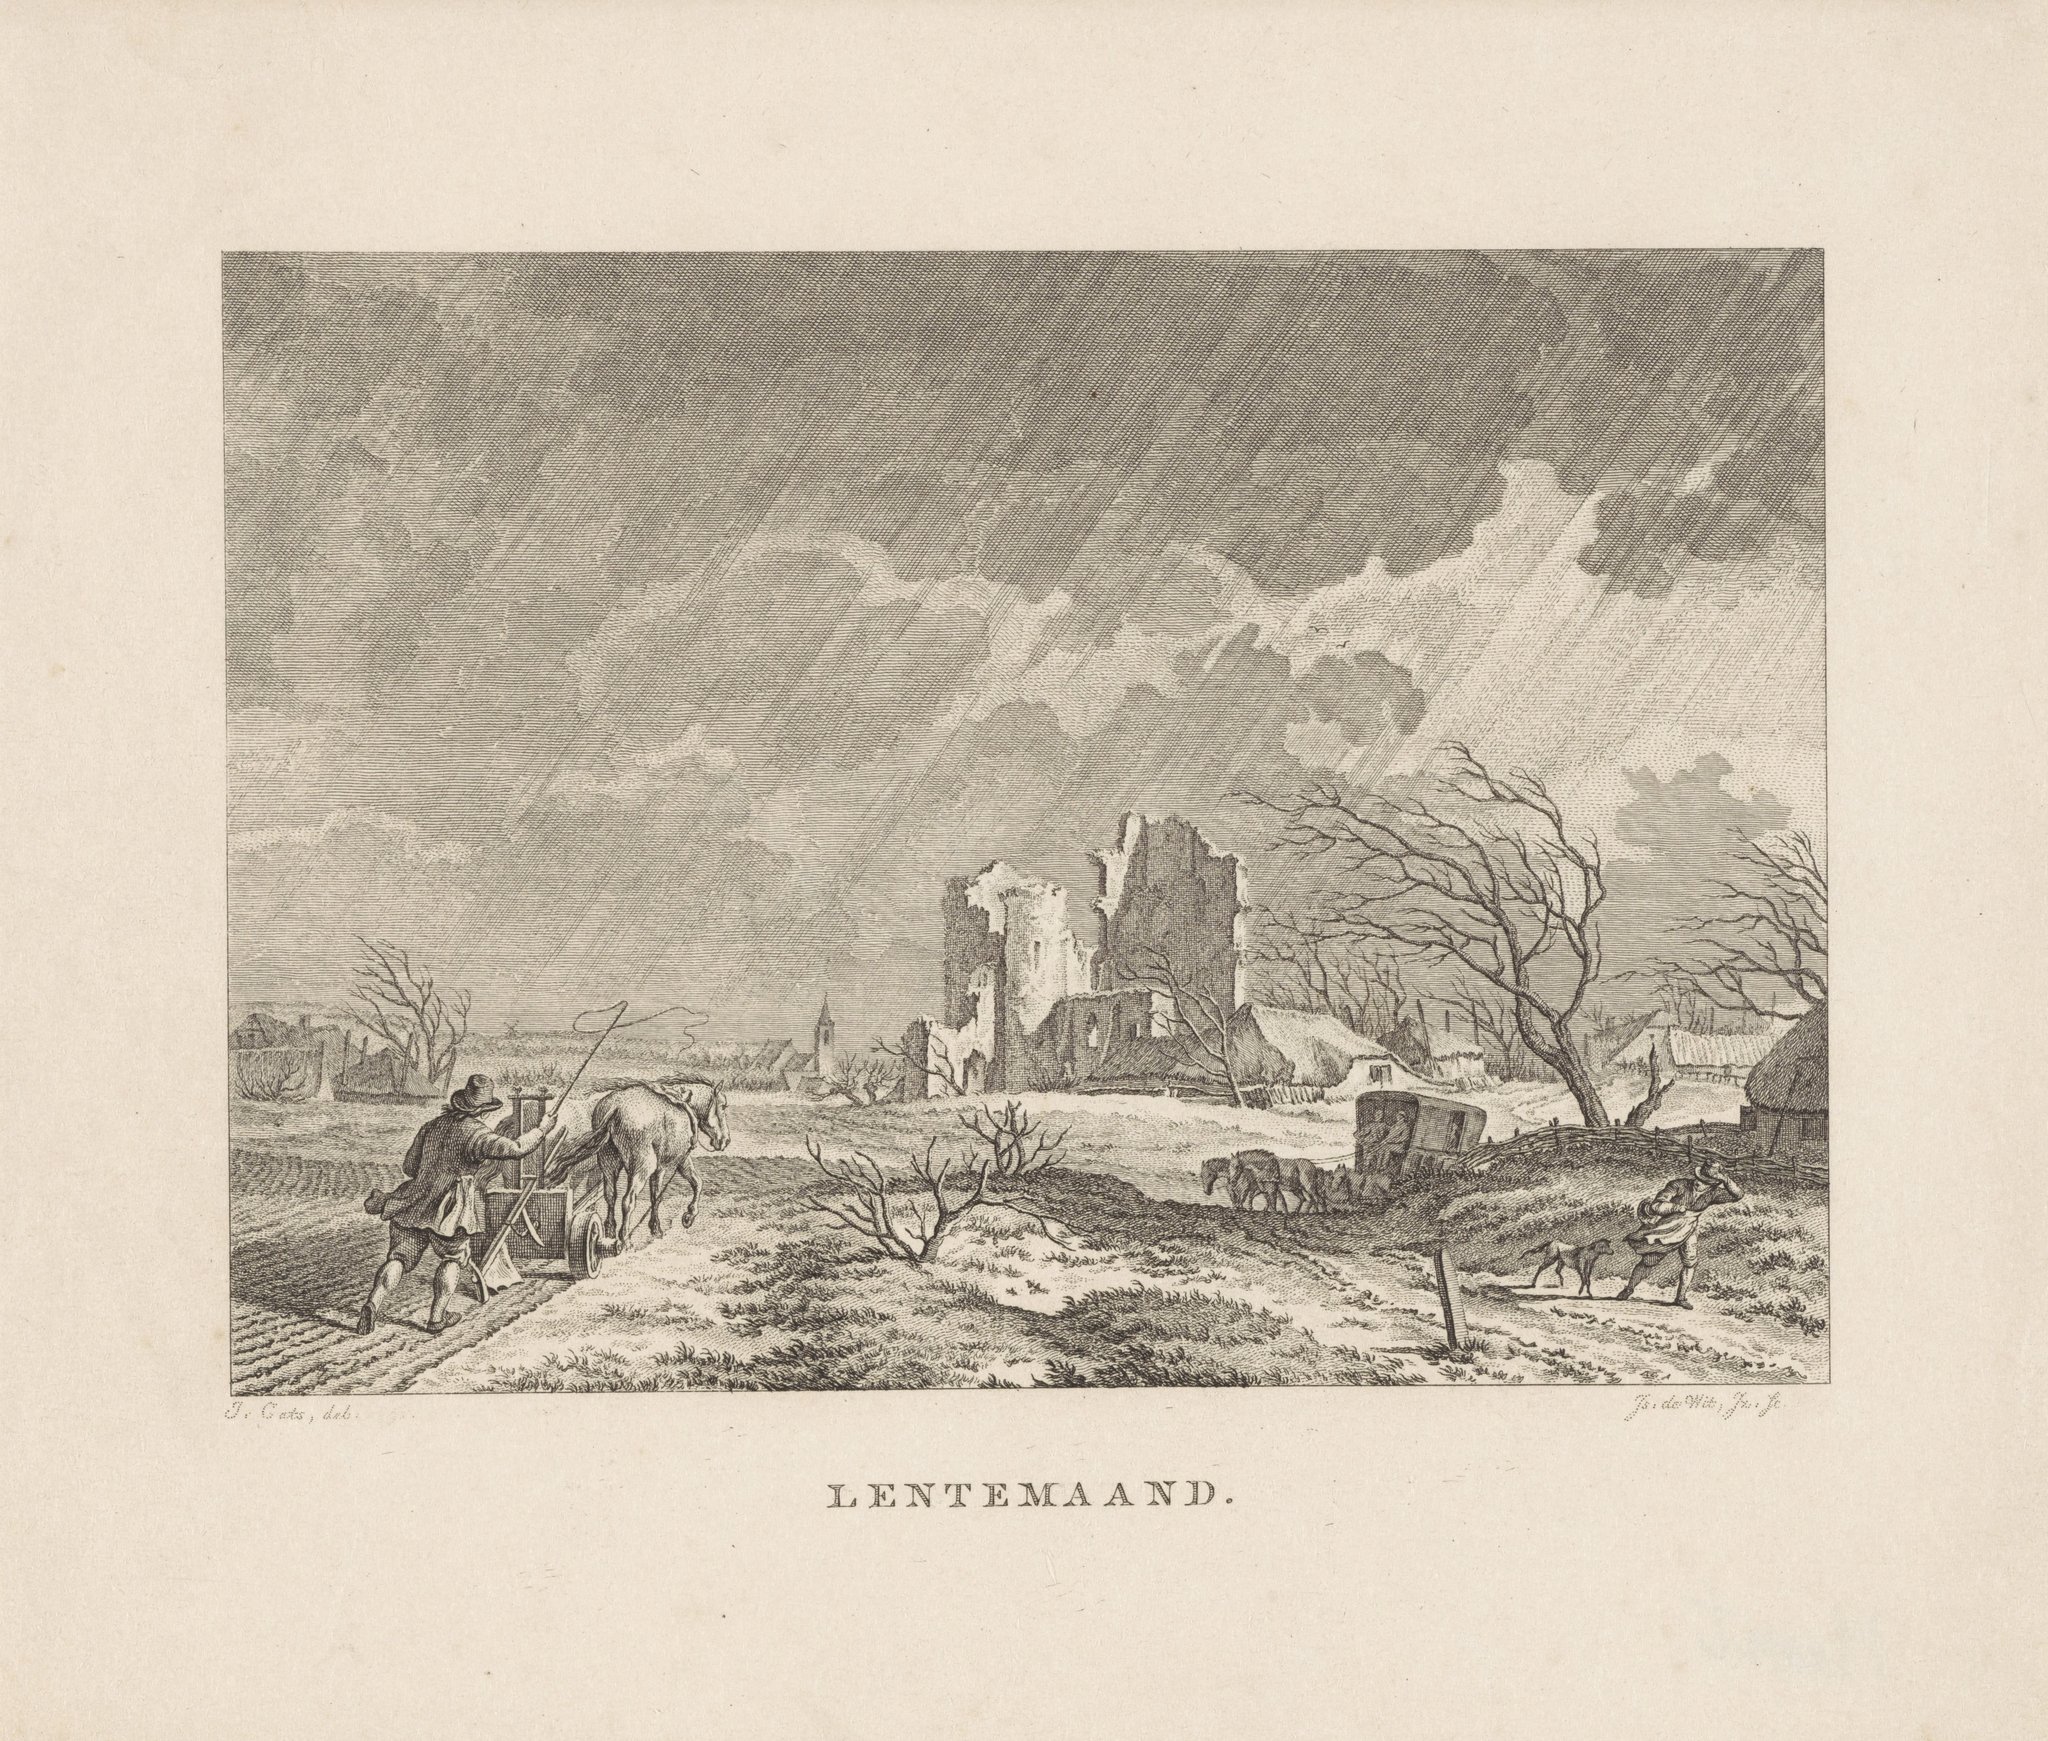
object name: print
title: De twaalf maanden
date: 1807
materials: paper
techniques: etching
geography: haarlem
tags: downpour, rain shower, march and its 'labours' (+ with scenes showing human occupations ~ seasons and months), landscape with ruins, ploughing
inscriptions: signature: ‘Is. de Wit Jz. fc’, signature: ‘J. Cats del.’, title: ‘LENTEMAAND’, collector's mark: Lugt 2228